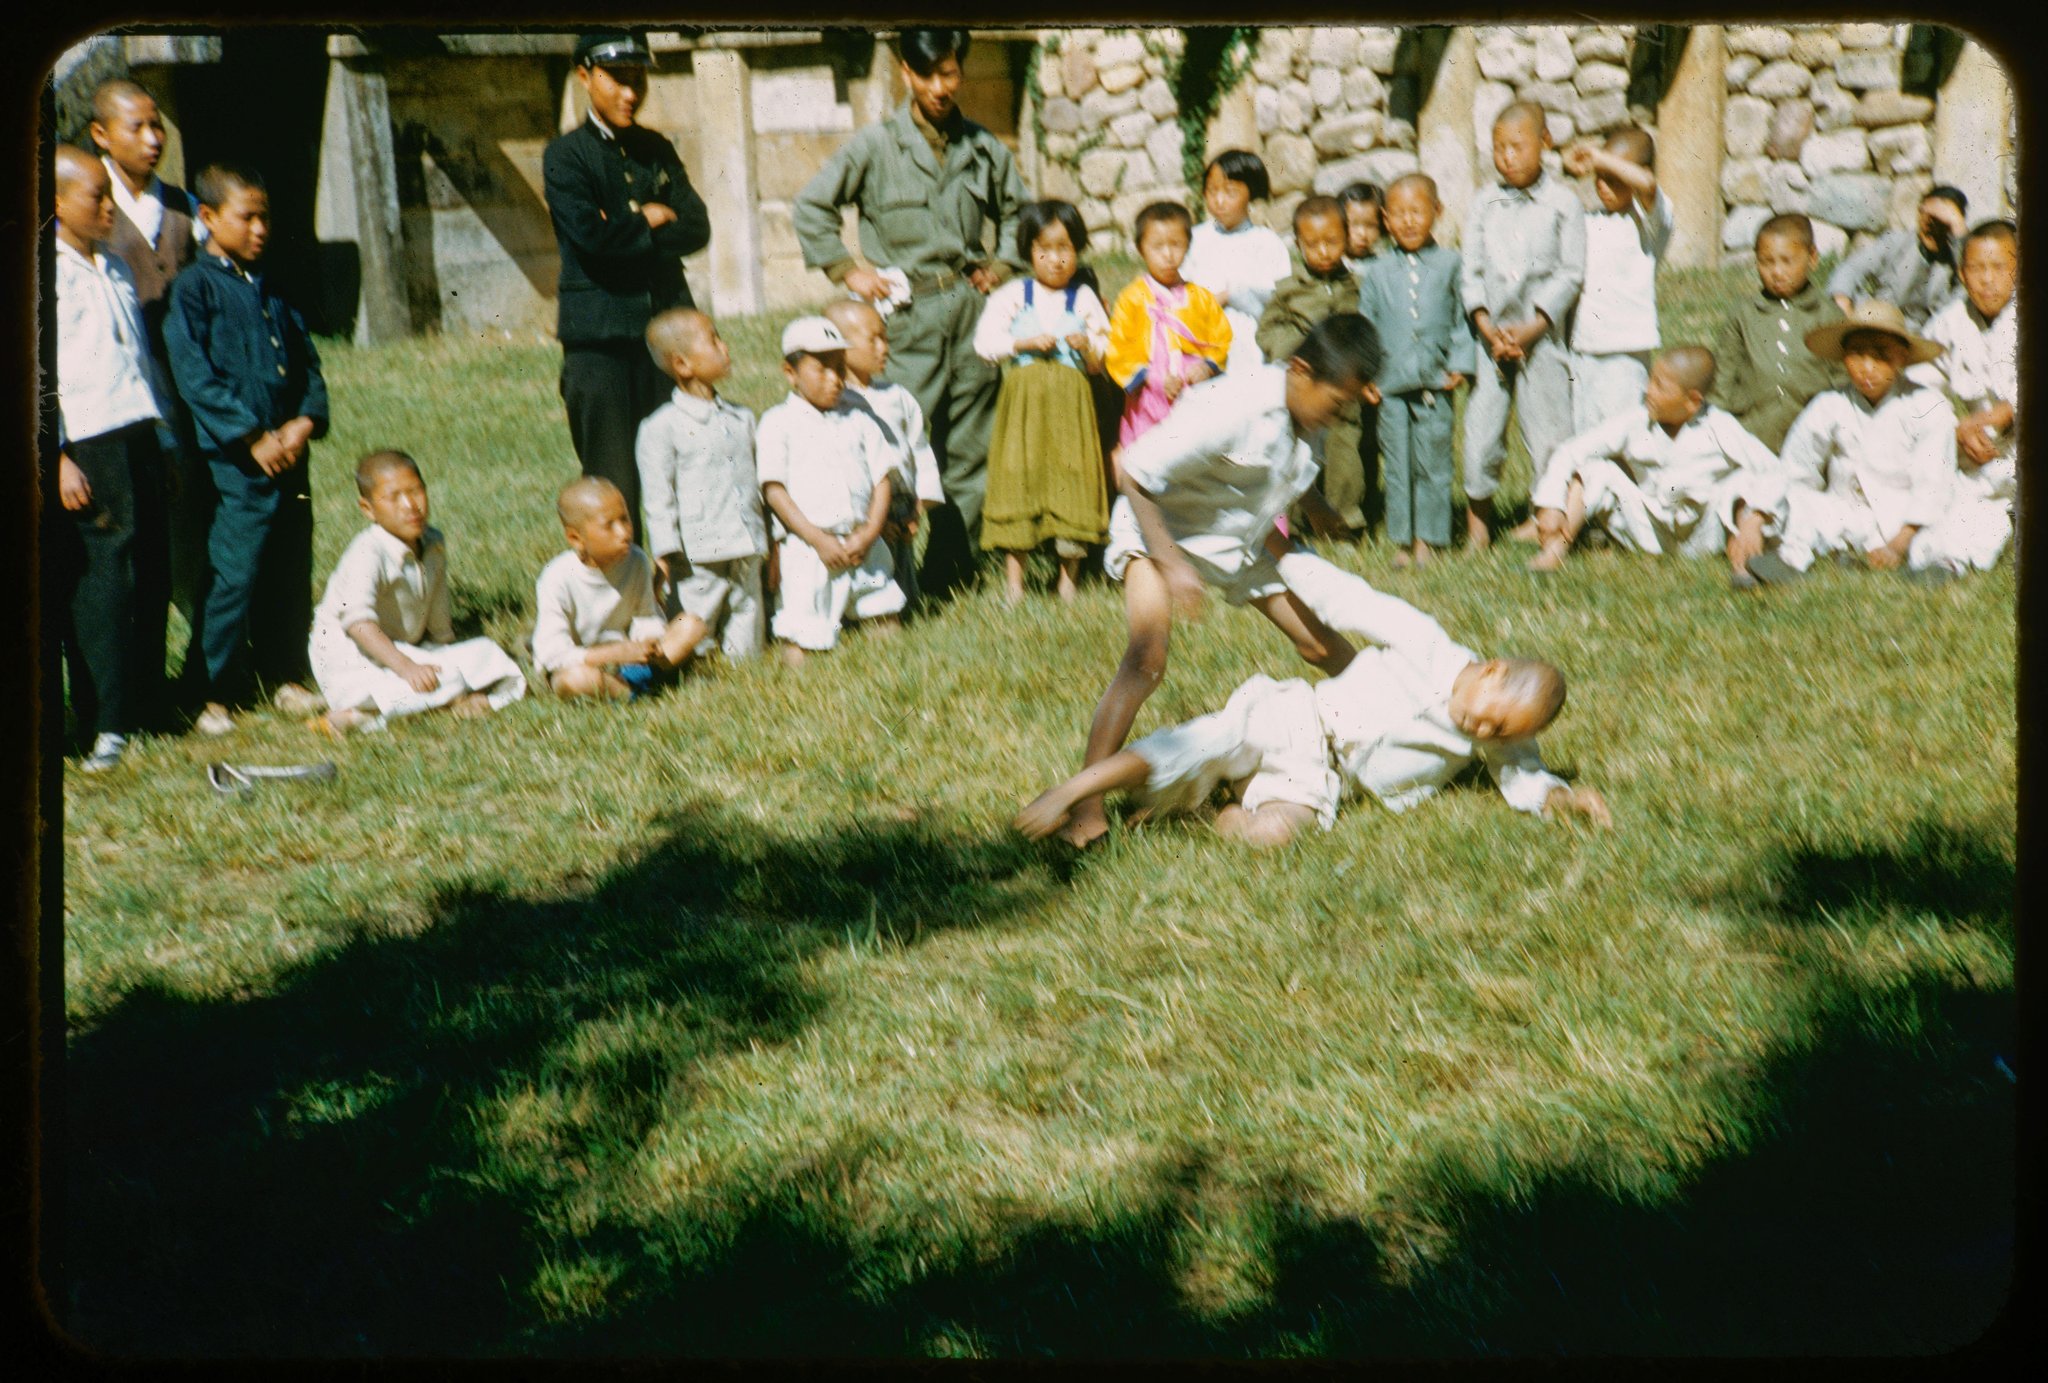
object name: color slide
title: Oorlog in Korea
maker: david ketel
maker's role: diplomaat, sinoloog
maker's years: 1913-2008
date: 1951-1953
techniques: slide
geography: korea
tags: united nations